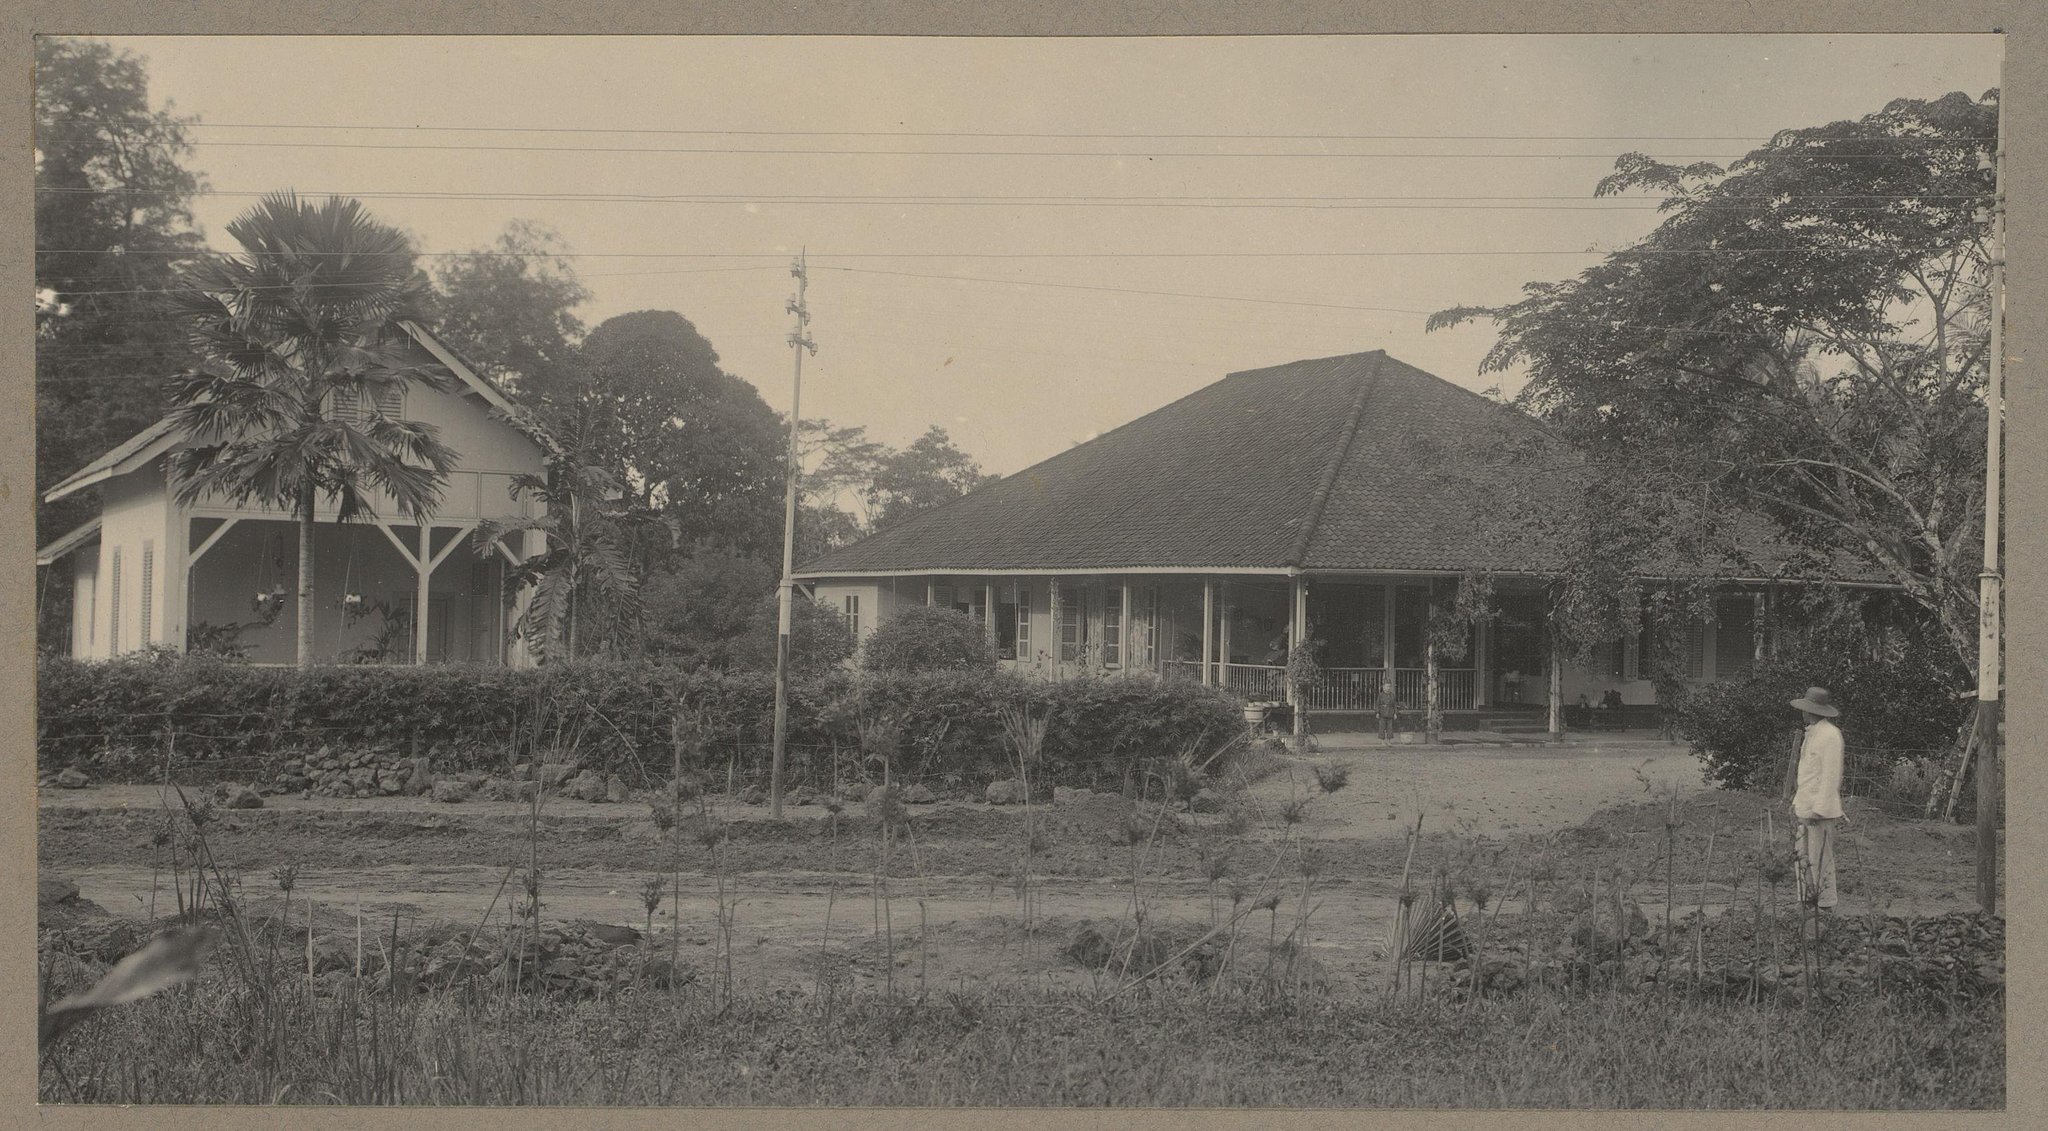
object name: photograph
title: Pangkalpinang. Woning van den Eur: Geneesheer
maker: Anonymous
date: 1914-1919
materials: photographic support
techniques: gelatin silver print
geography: bangka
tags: robert julius boers, colonial system, mining, villa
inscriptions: inscription: ‘Pangkalpinang. Woning van den Eur: Geneesheer.’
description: Woning met paviljoen van de Europese geneesheer van het hospitaal van de Banka-tinwinning te Pangkalpinang. Onderdeel van het fotoalbum aangeboden aan Robert Julius Boers bij zijn vertrek naar Nederland in 1919 door het personeel van de Banka-tinwinning.